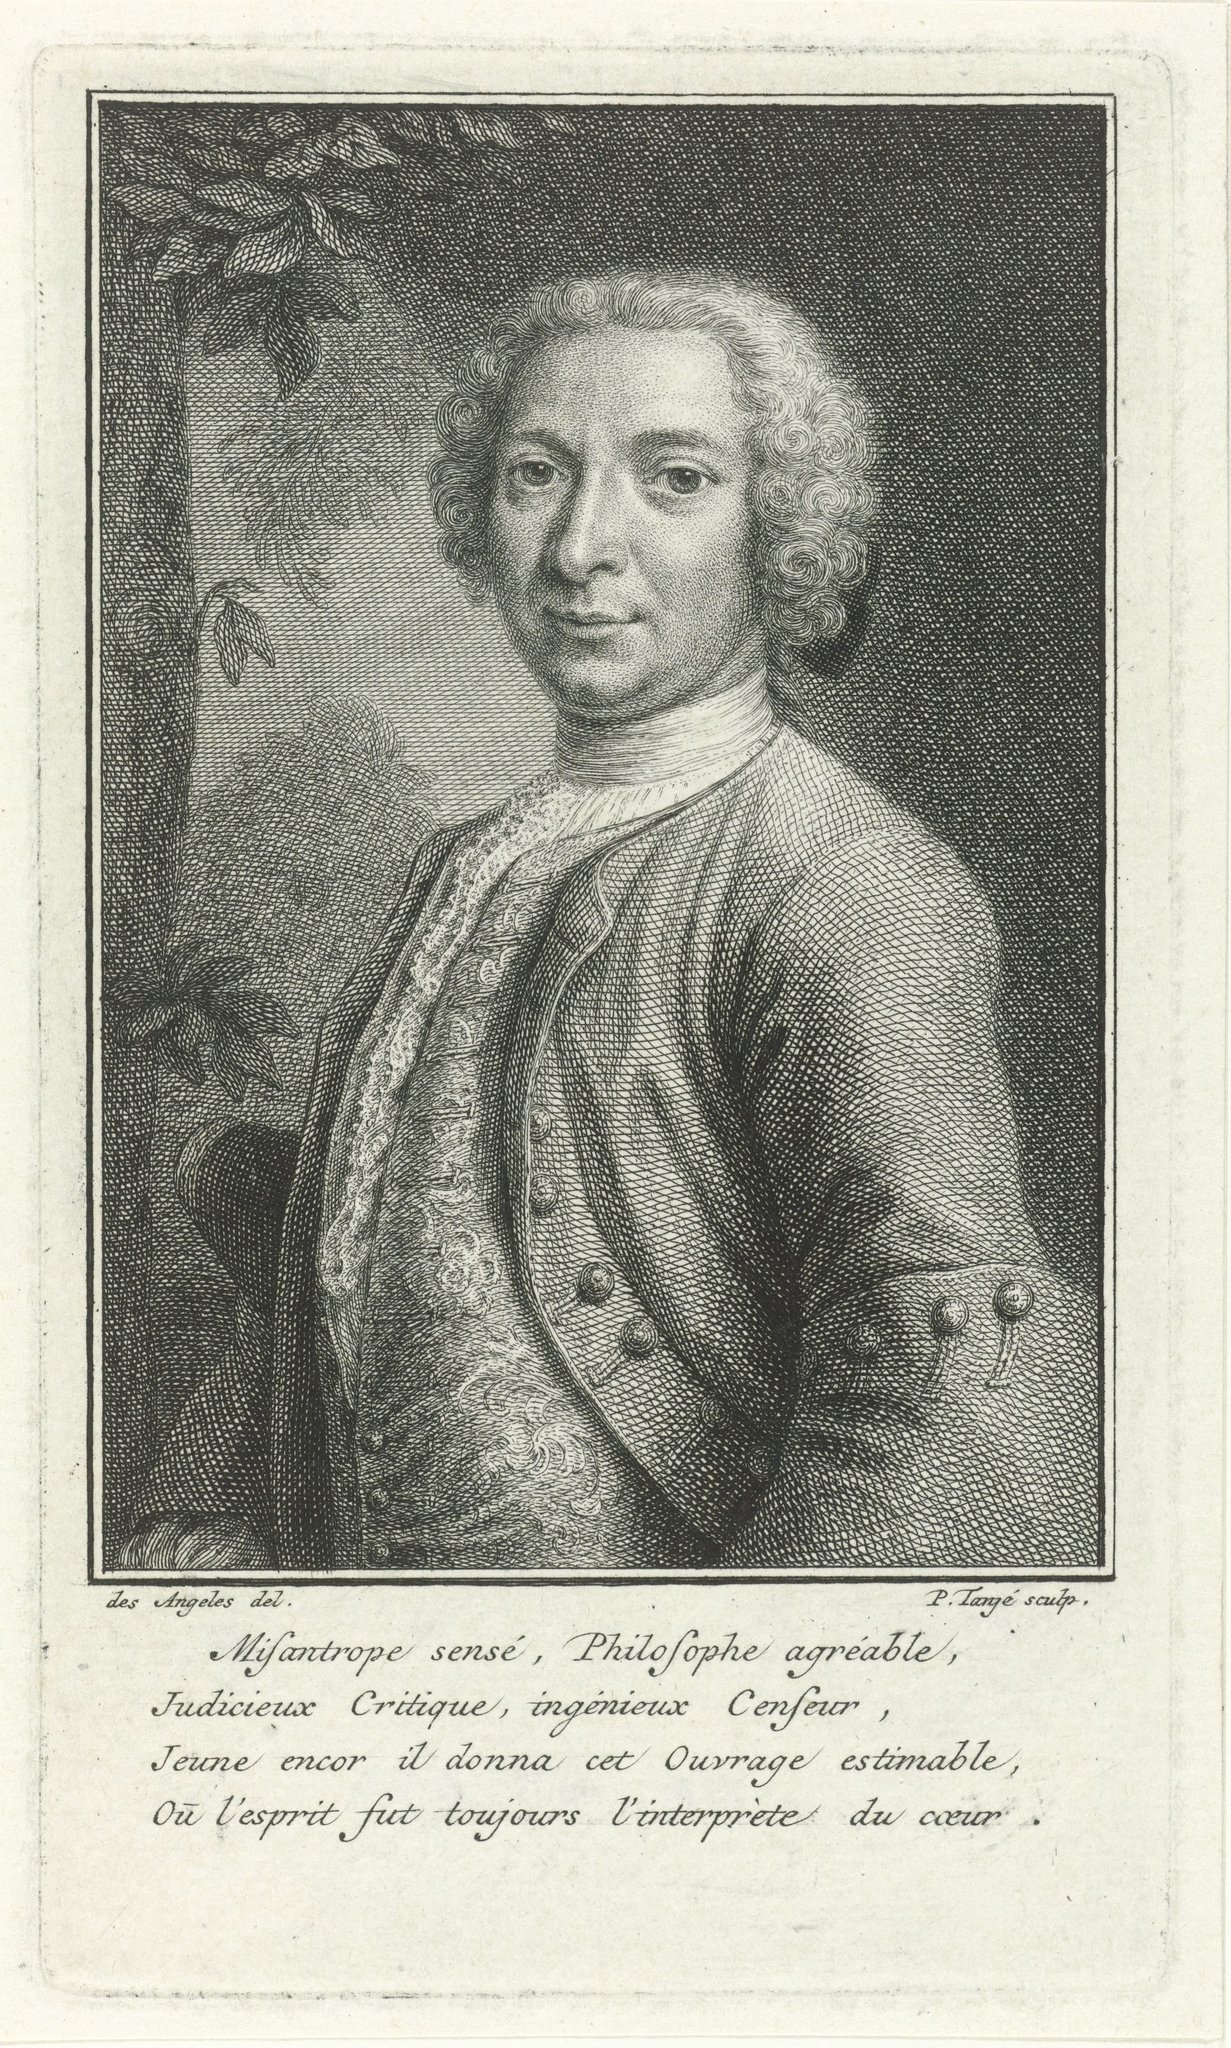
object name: print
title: Portret van Justus van Effen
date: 1716-1761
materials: paper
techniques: engraving, etching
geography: amsterdam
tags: utrecht, den bosch, trees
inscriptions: collector's mark: Lugt 240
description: Portret van schrijver en dichter Justus van Effen staande naast een boom. Onderaan in de marge een vierregelig vers in het Frans.